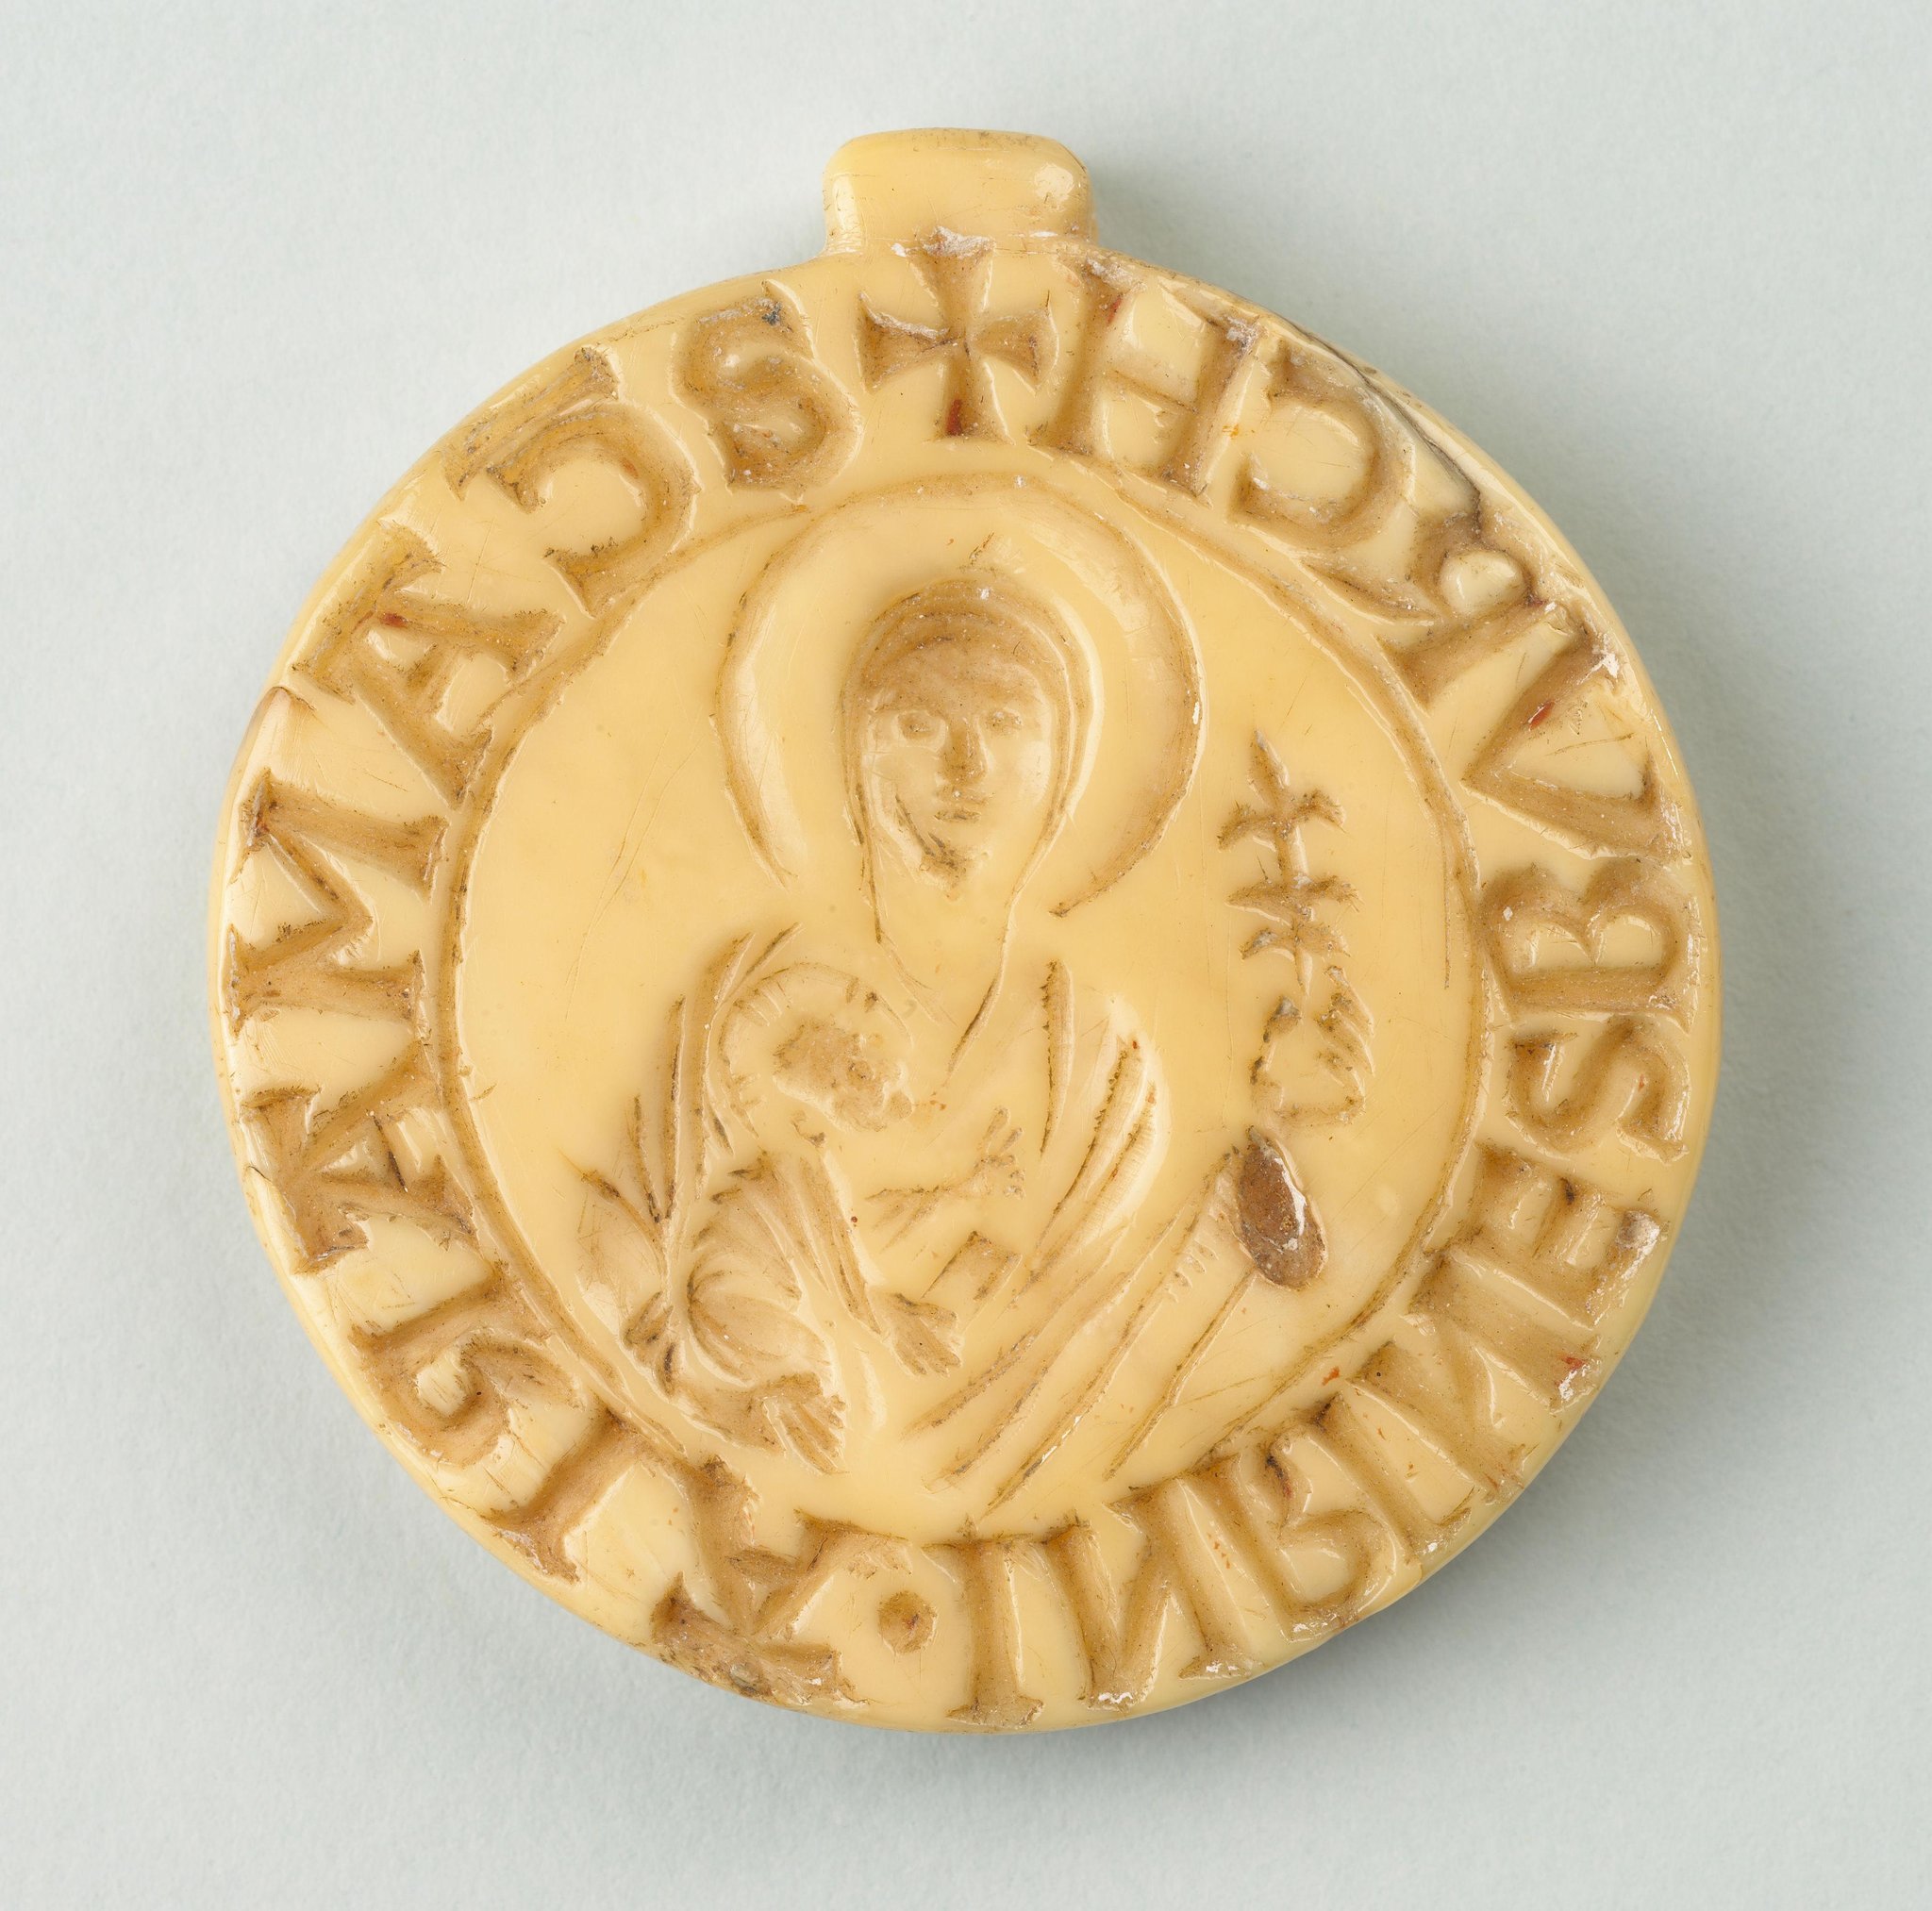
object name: zegelstempel, lakstempel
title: Convent seal of Rijnsburg Abbey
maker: Anonymous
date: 1340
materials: ivory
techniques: cutting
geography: netherlands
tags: madonna: mary standing (or half-length), christ-child close to her bosom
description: Rond conventszegel van de abdij van Rijnsburg. Boven het kruisteken in het randschrift een oblong uitsteeksel. Afgebeeld Maria ten halven lijve met het Christuskind op schoot. Maria is frontaal weergegeven. Genimbeerd. Byzantijns gewaad, het hoofd bedekt door een doek. In de linkerhand een takje (lelie). De rechterhand ondersteunt het Christuskind, dat met beide handen naar het takje grijpt. Het draagt een lang gewaad. Kruisnimbus. Opschrift: SCA MARIA . IN RINESBURCH +/ rand.